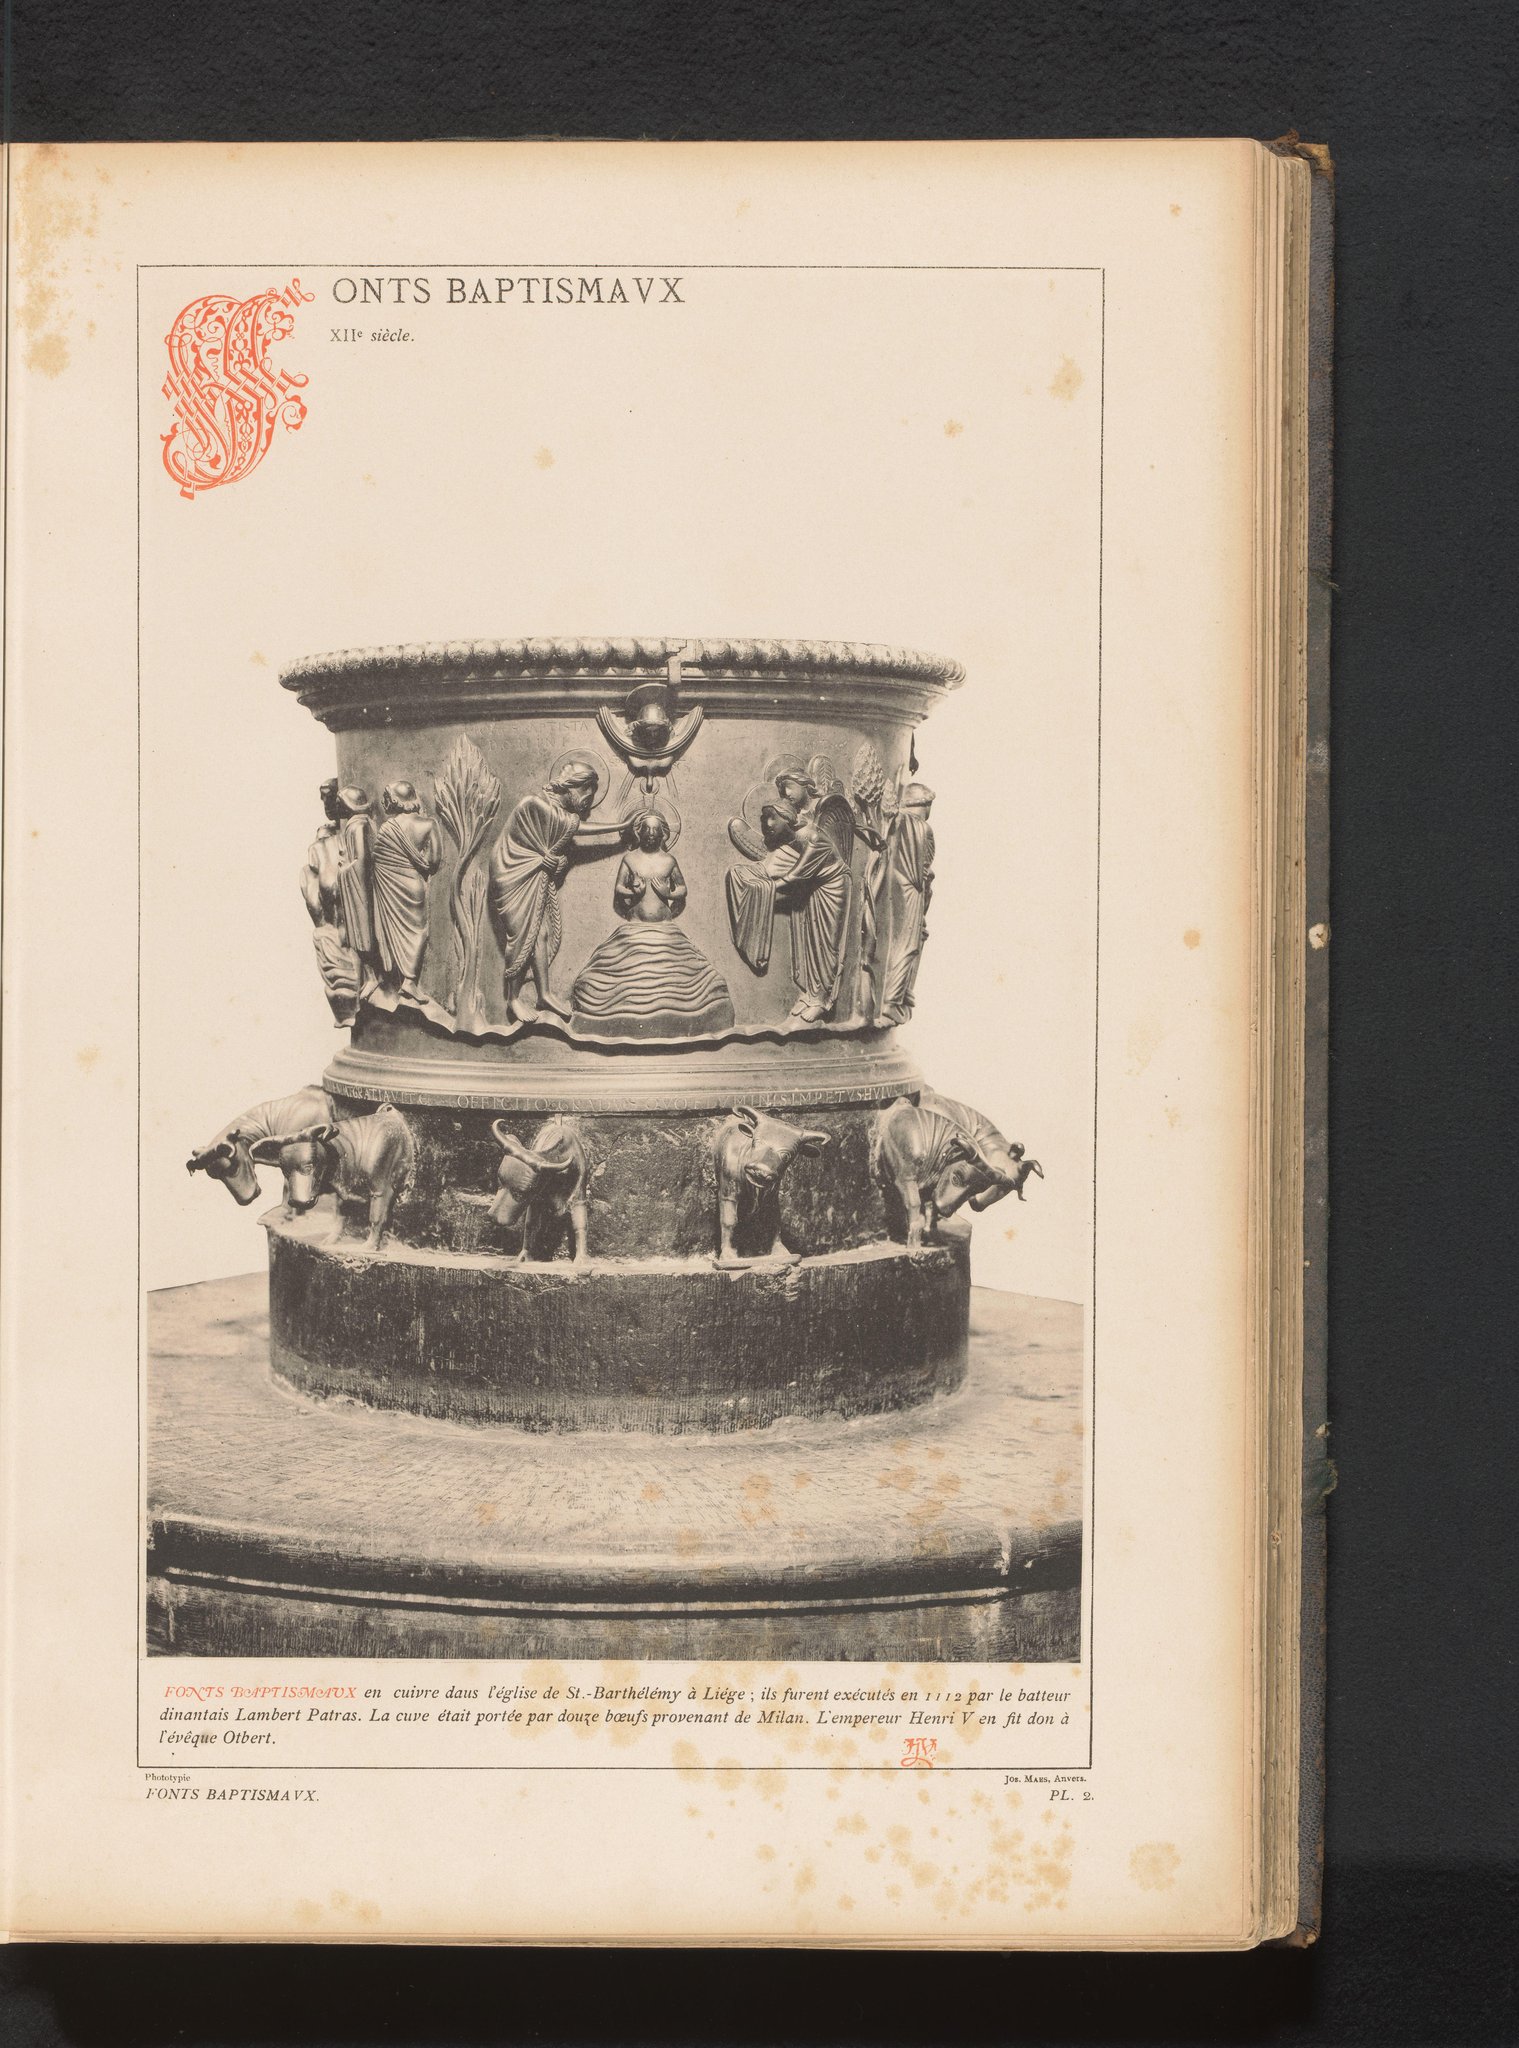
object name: page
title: Koperen doopvont in de Sint-Bartholomeüskerk in Luik, België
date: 1882-1887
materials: paper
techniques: photograph, photolithography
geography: antwerp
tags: baptismal font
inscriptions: monogram: ‘JJvY’, inscription: ‘FONTS BAPTISMAUX en (...)’, inscription: ‘FONTS BAPTISMAUX. - PL. 2.’